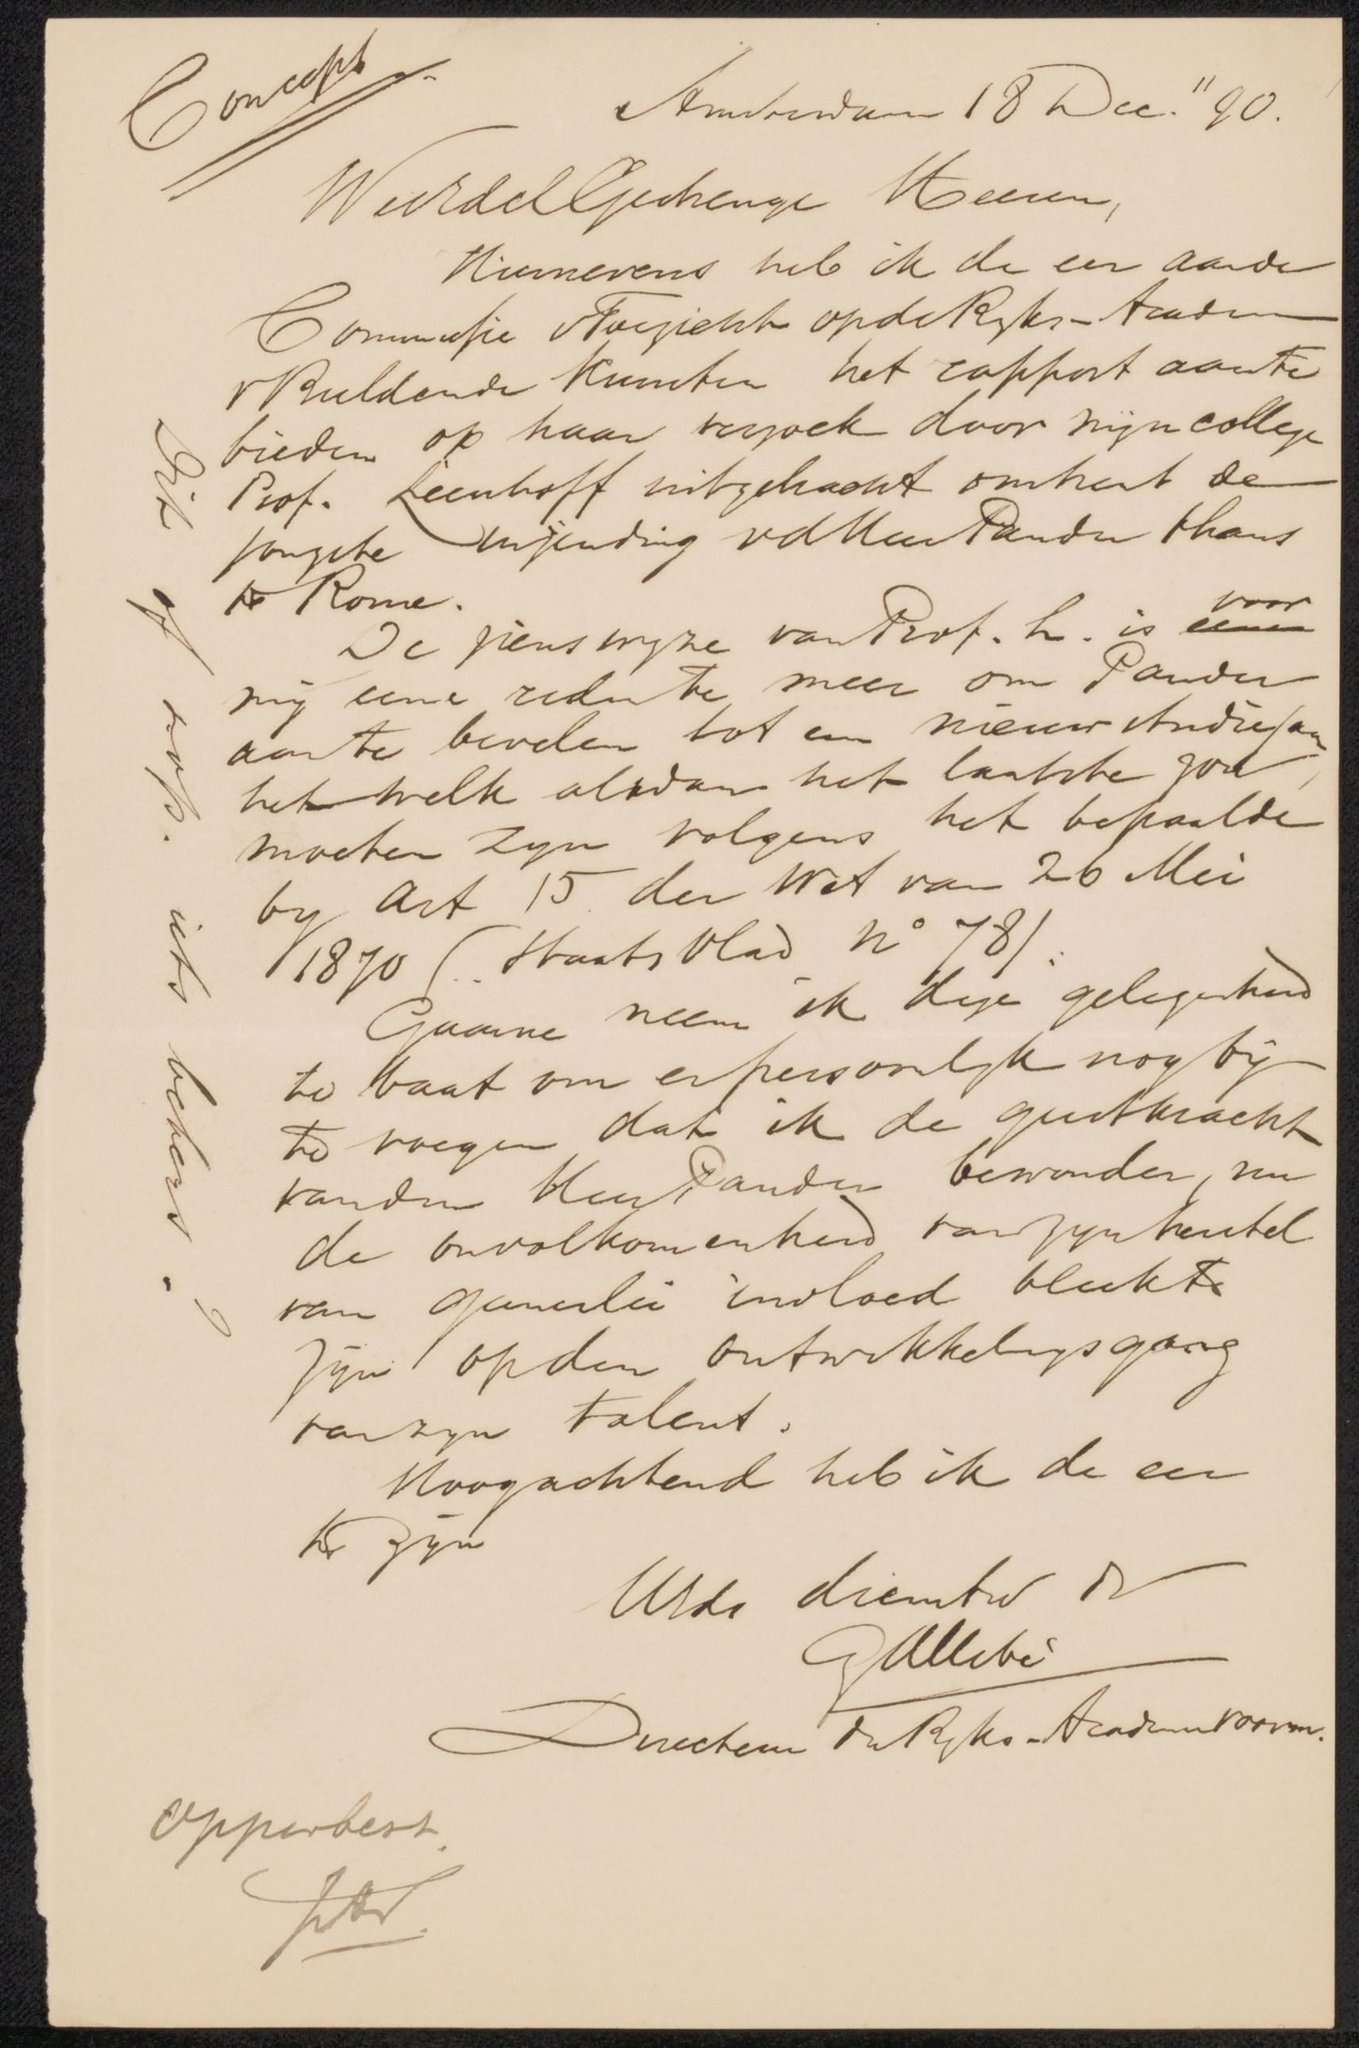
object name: letter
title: Conceptbrief aan de Commissie van Toezicht op de Rijksakademie van Beeldende Kunsten te Amsterdam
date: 1890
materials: ink, paper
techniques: pen, writing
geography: amsterdam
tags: ferdinand leenhoff, rome, designer, sculptor, pier pander, education, tuition of the artist (in general), diseases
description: Brief bevat een aantekening van een onbekende persoon.